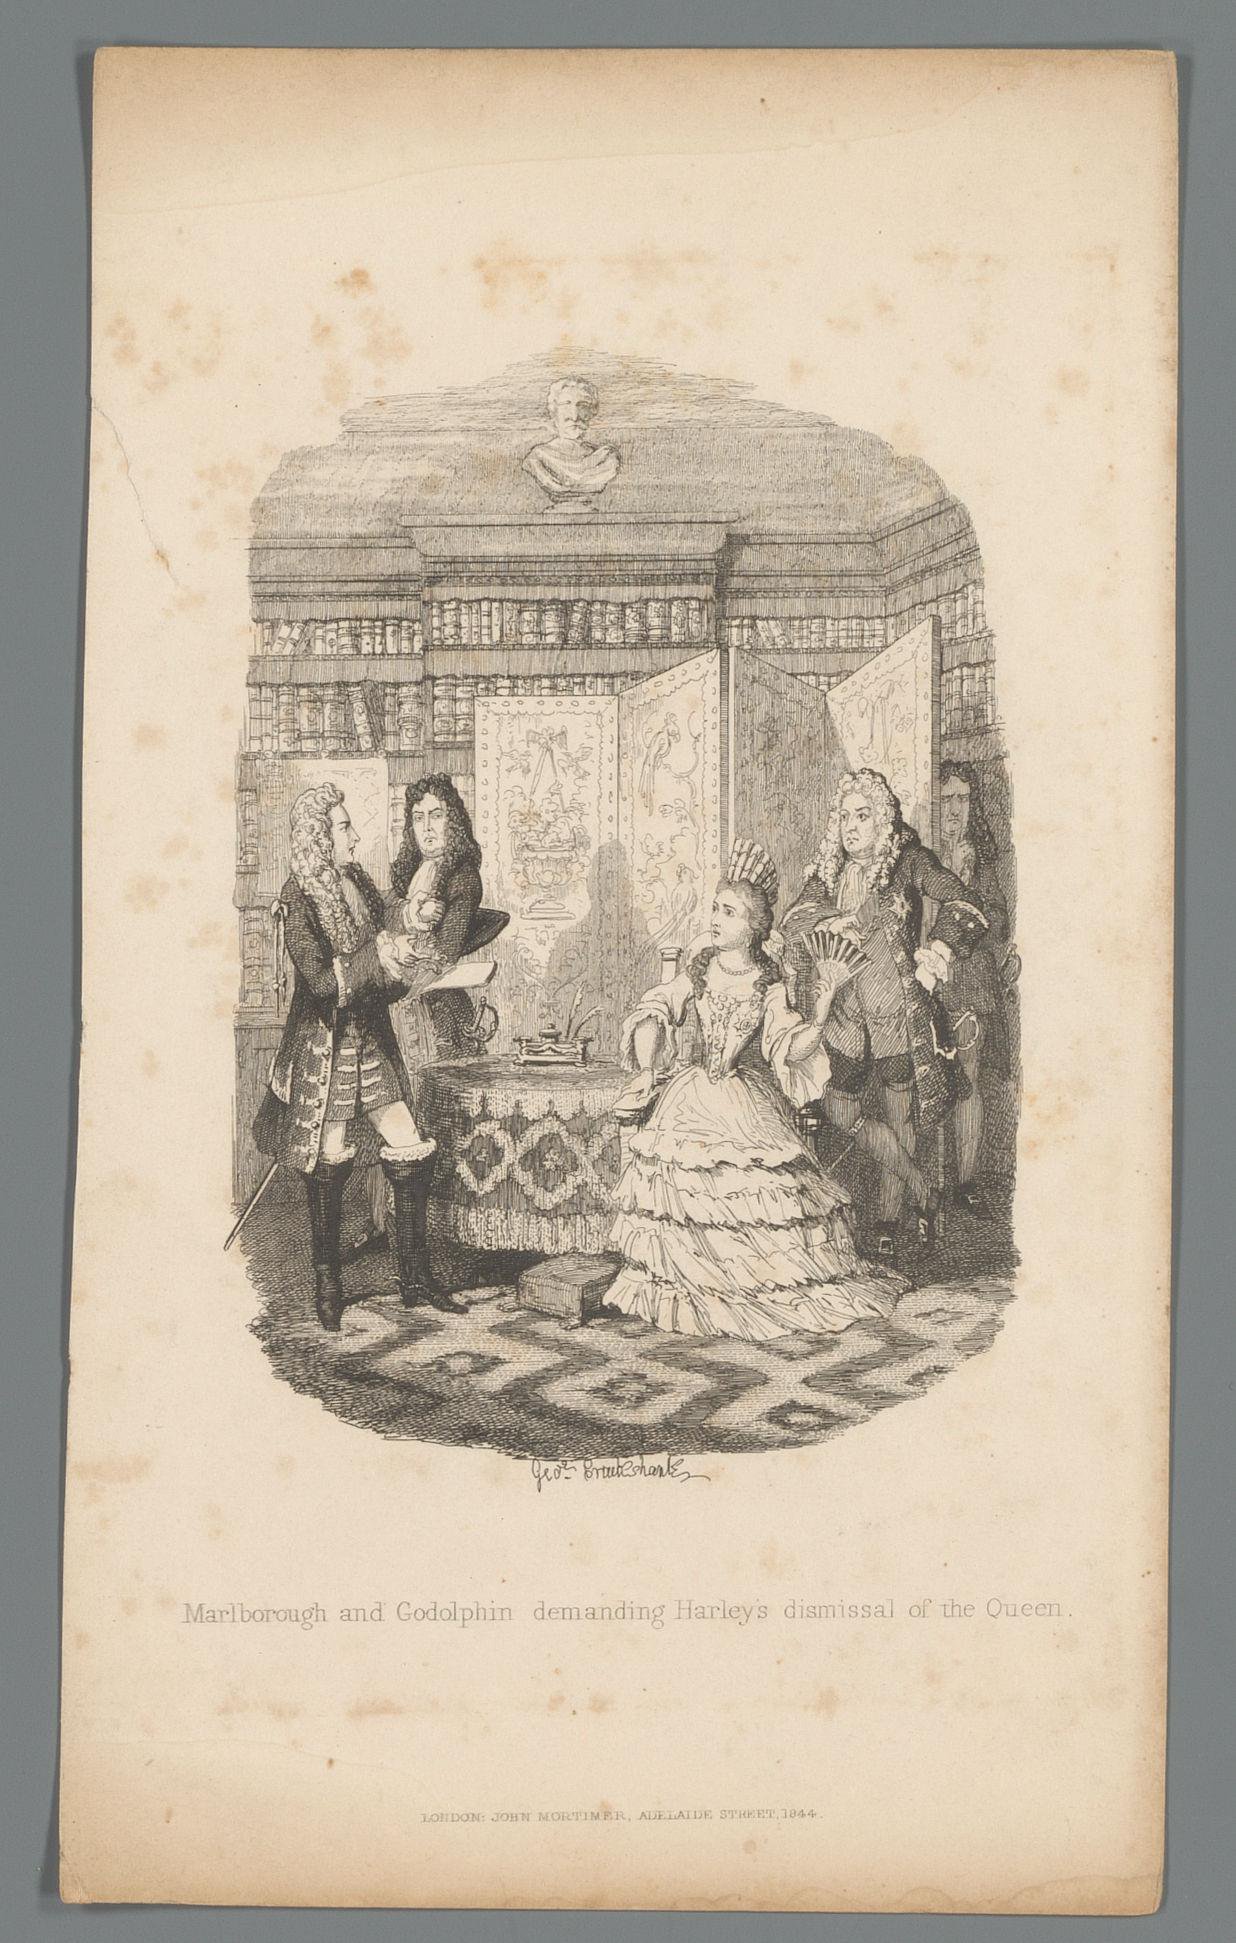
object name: cartoon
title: Marlborough en Godolphin vragen om het ontslag van Harley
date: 1844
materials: paper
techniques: etching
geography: london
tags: london, anna stuart (koningin van engeland en schotland), throne - bb - female ruler, political caricatures and satires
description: Marlborough en Godolphin vragen bij koningin Anna om het ontslag van Harley. Illustratie voor een uitgave van "St James's, or the Court of Queen Anne" van Ainsworth, 1844.